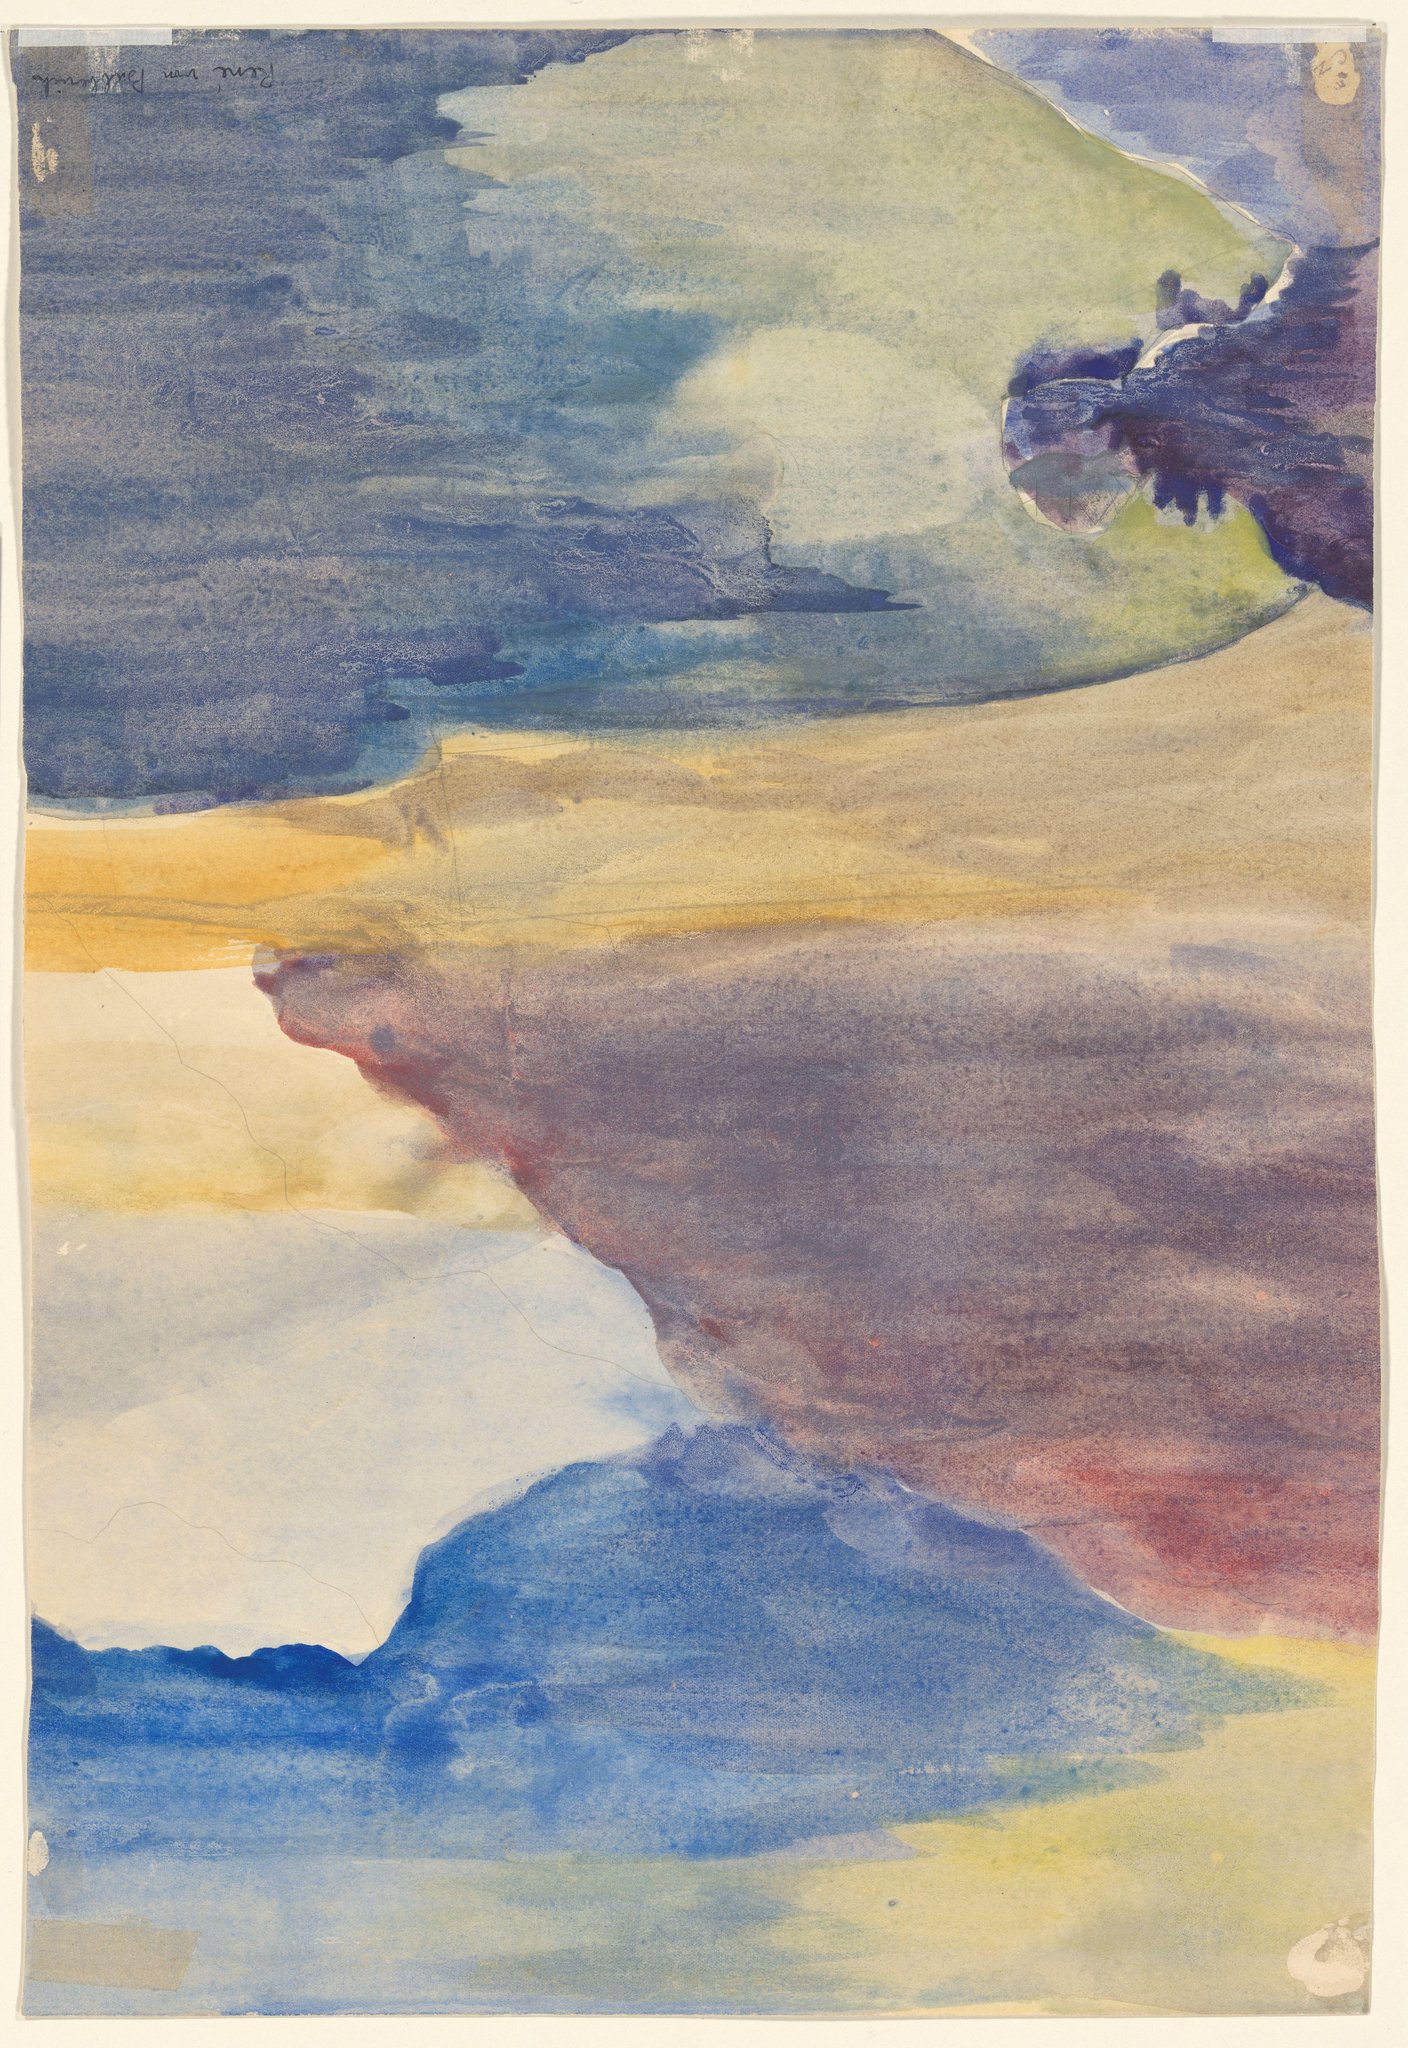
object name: drawing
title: Fantasielandschap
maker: karel de nerée tot babberich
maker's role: draughtsman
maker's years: 1880-1909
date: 1905-1907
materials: chalk, paint, paper, pencil, watercolor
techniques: drawing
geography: switzerland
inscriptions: inscription: ‘René von Babberich’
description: Een fantasielandschap met bergen en een meer.